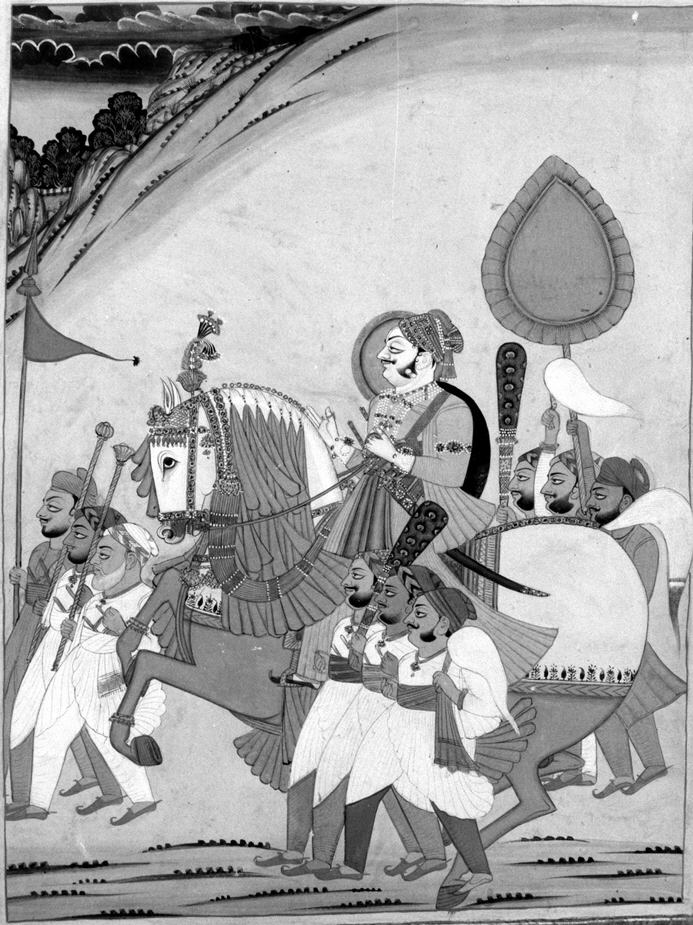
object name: painting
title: Raja on Horseback with Attendants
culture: indian, rajasthan, kota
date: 1800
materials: gold, paper, silver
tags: men,horses